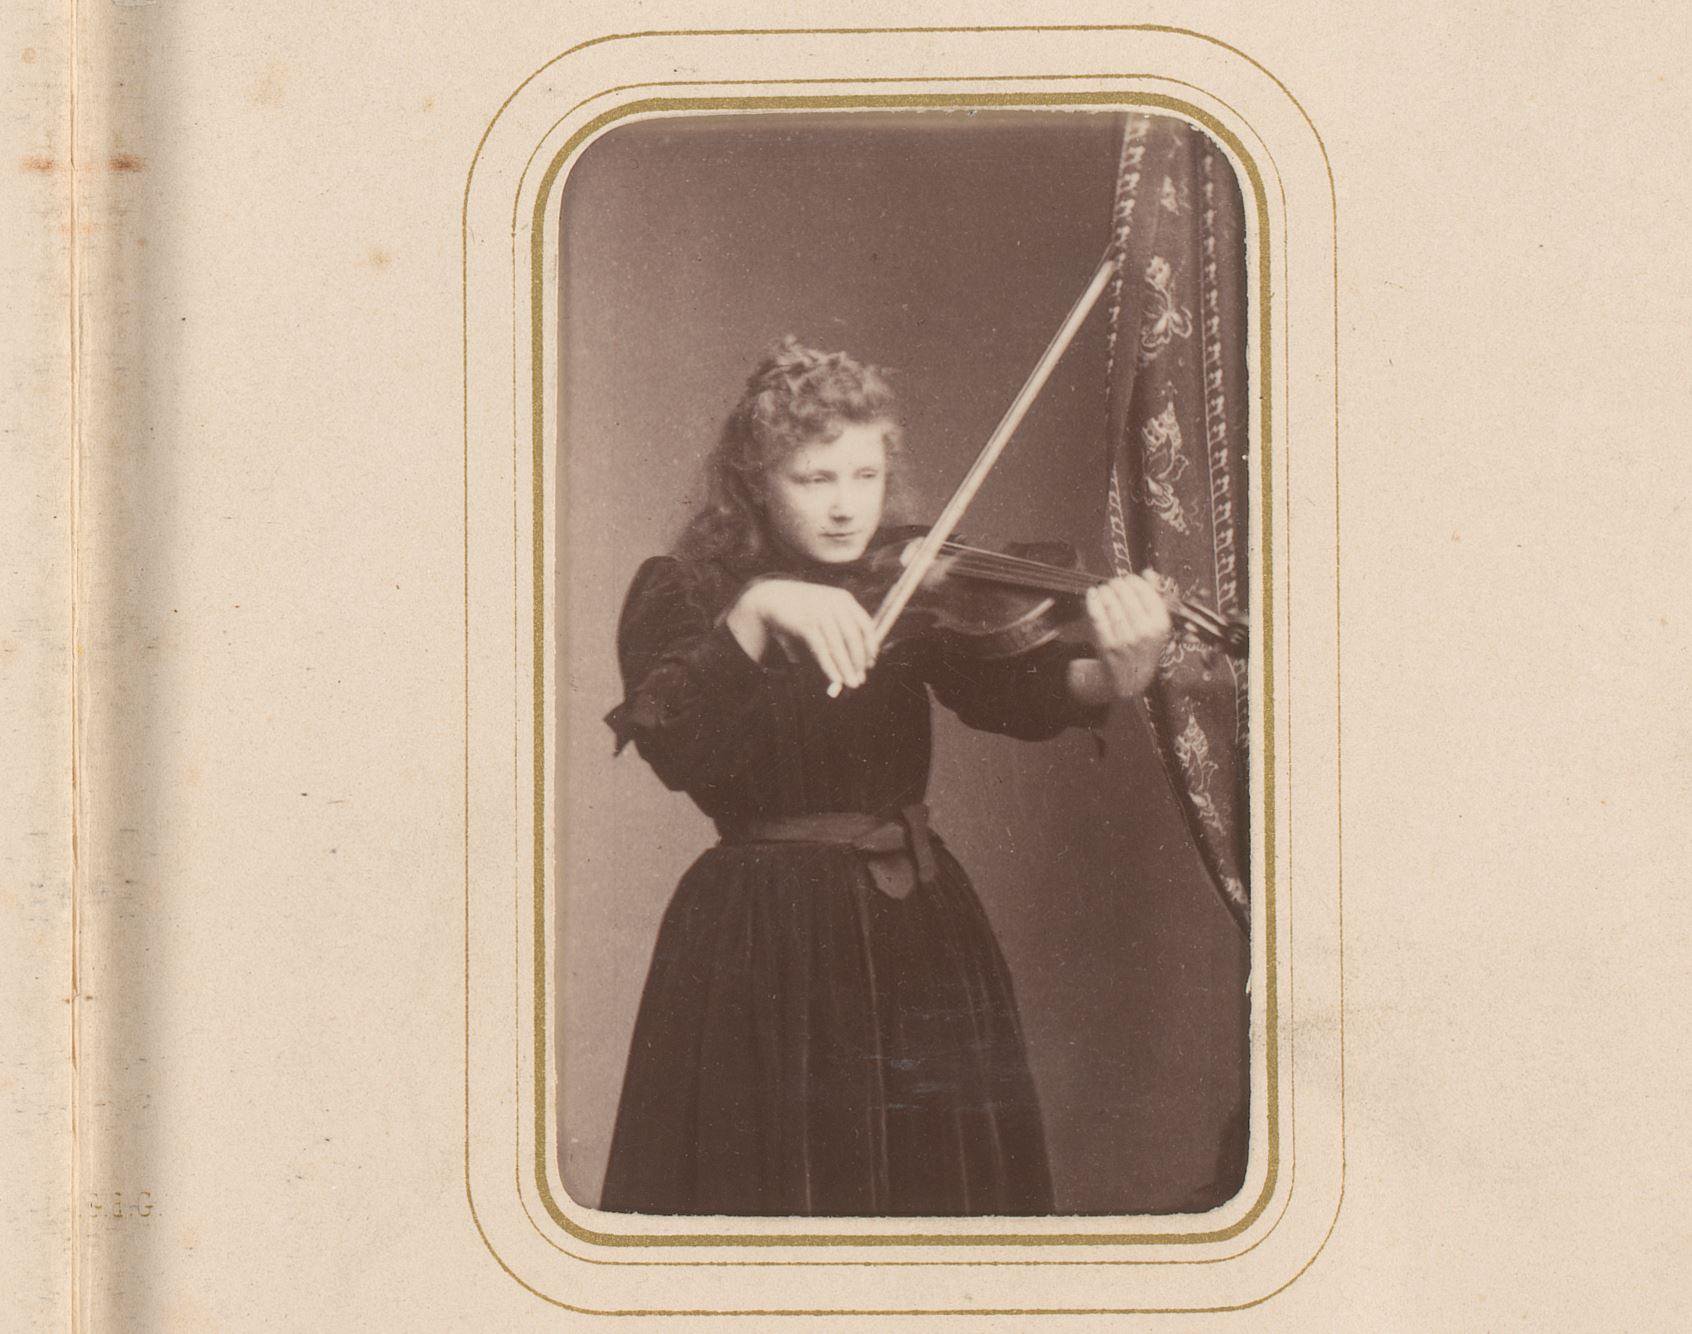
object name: carte de visite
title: Portret van een vioolspelend meisje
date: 1900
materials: cardboard, celluloid, photographic support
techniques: albumen print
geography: london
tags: historical persons - bb - woman, violin, fiddle, girl (child between toddler and youth)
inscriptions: inscription: ‘Head Studios:/ 211 & 213, REGENT STREET, W./ Hellis & Sons/ Branches/ (...)/ London/ ESTABLISHED OVER 25 YEARS.’